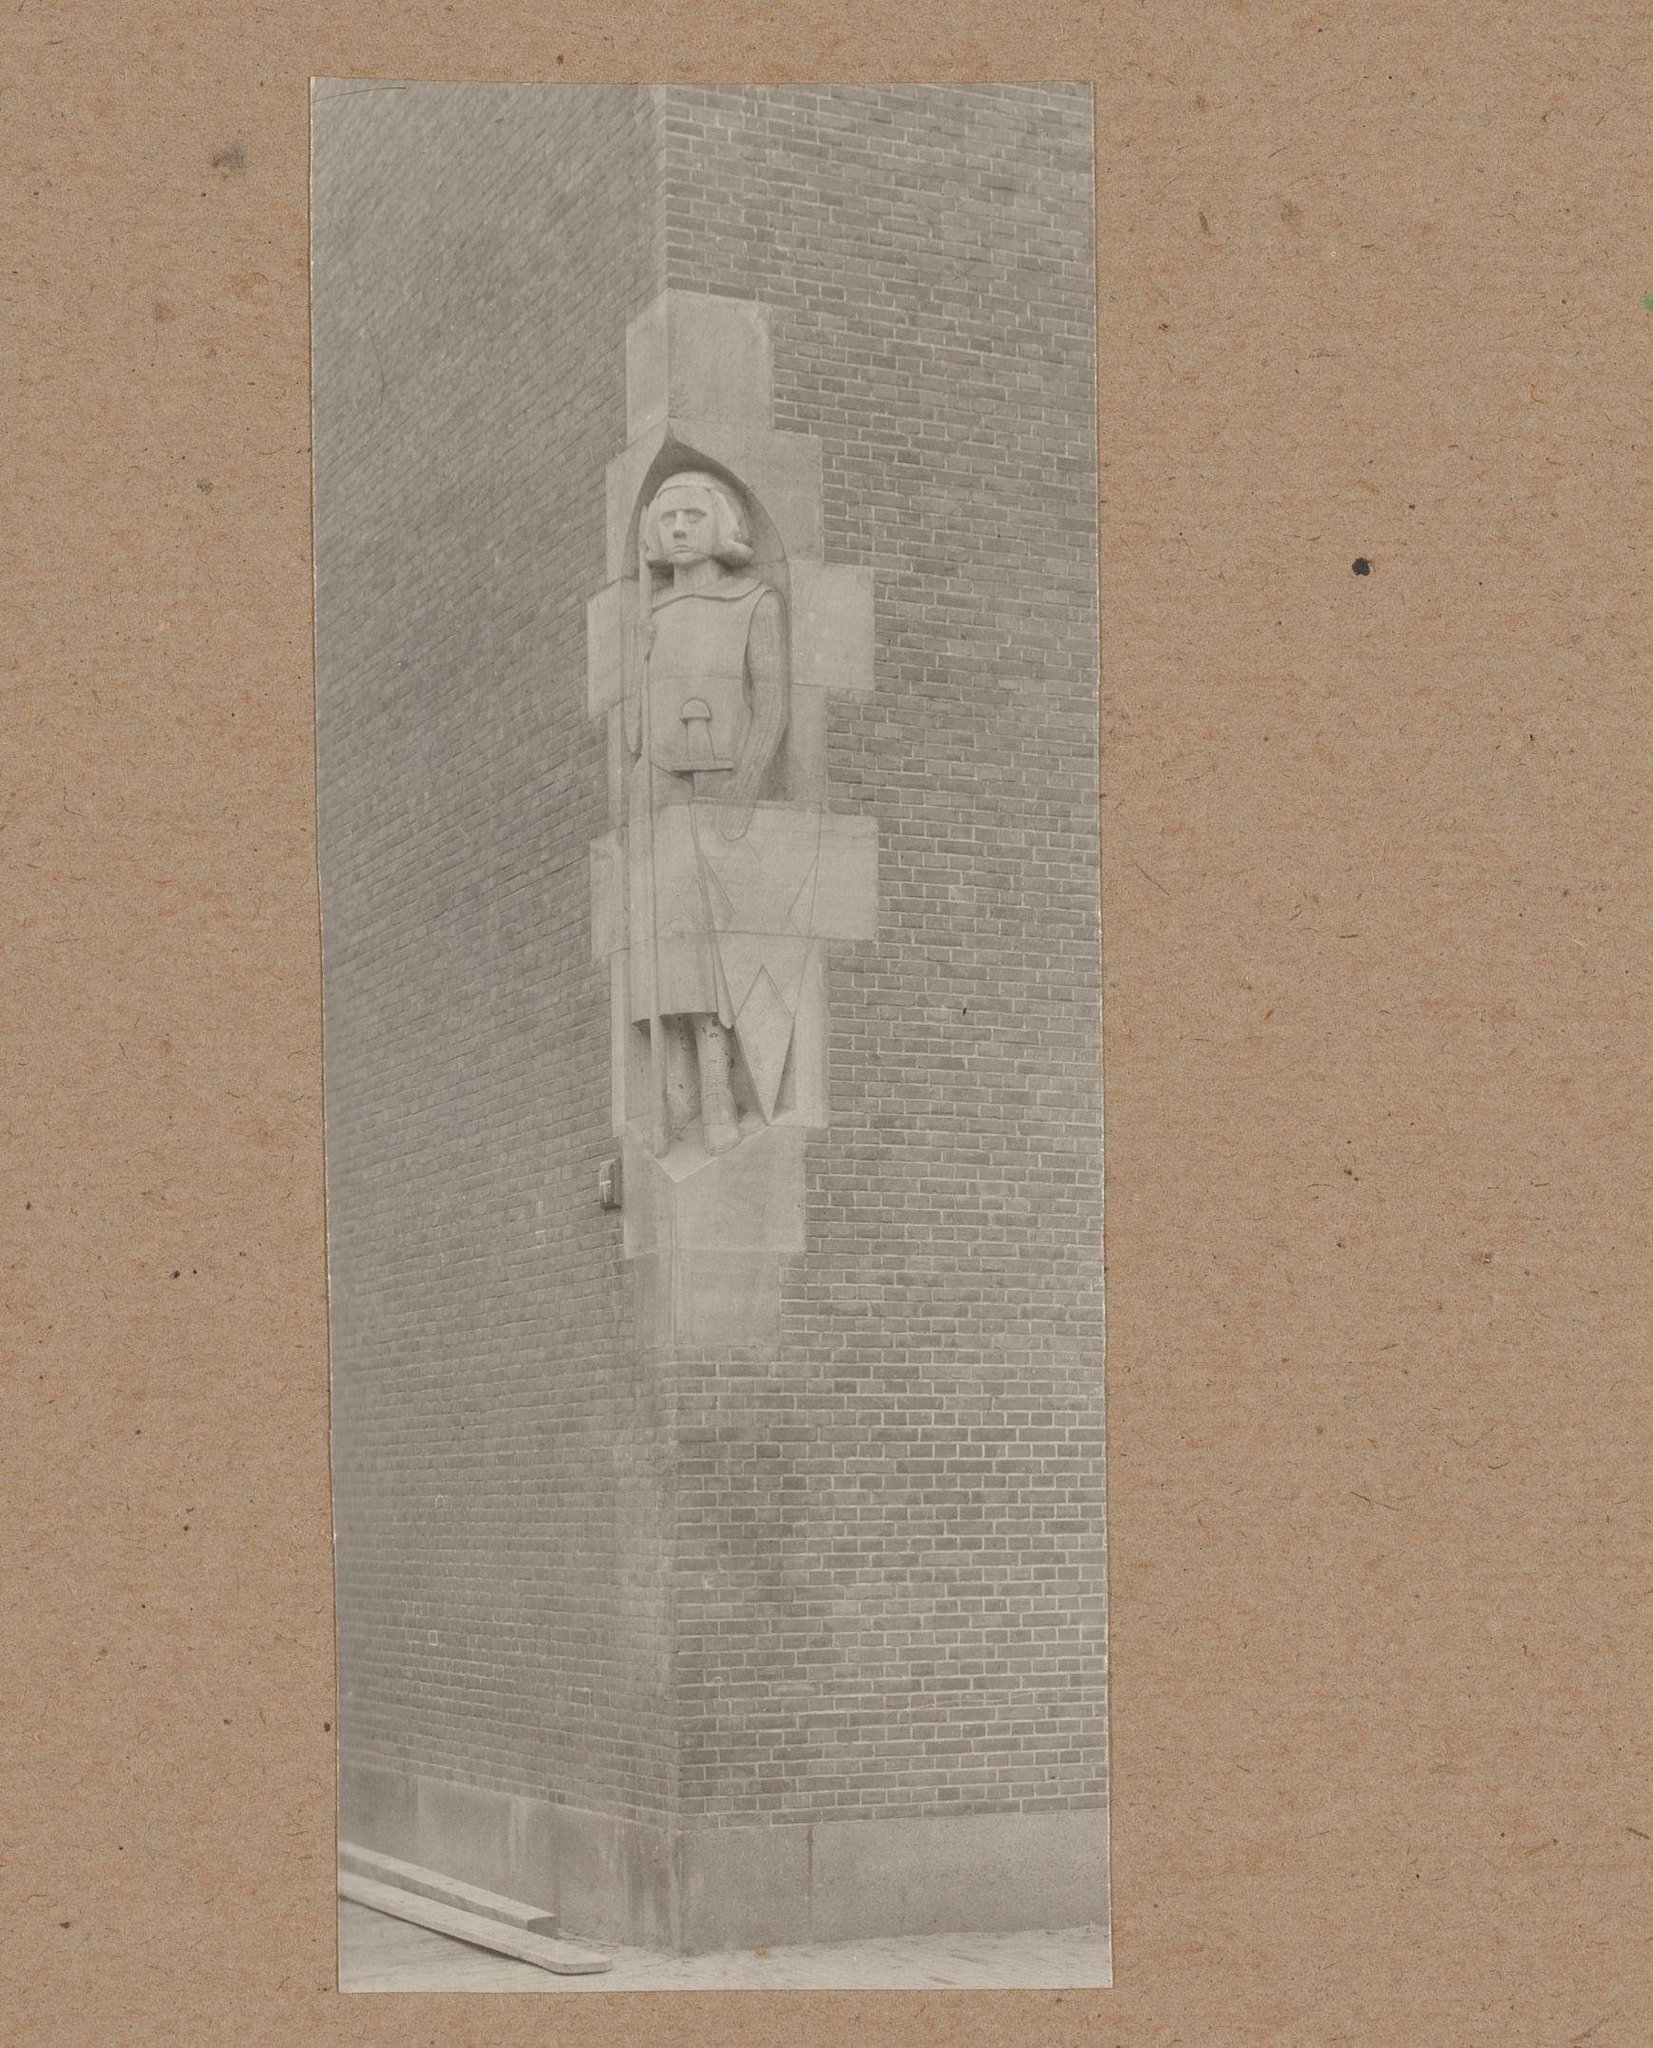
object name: photograph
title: Sculptuur van Gijsbrecht van Amstel aan de Beurs van Berlage te Amsterdam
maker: Anonymous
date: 1903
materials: paper, cardboard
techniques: gelatin silver print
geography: amsterdam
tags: piece of sculpture, reproduction of a piece of sculpture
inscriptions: number: ‘6 a b’